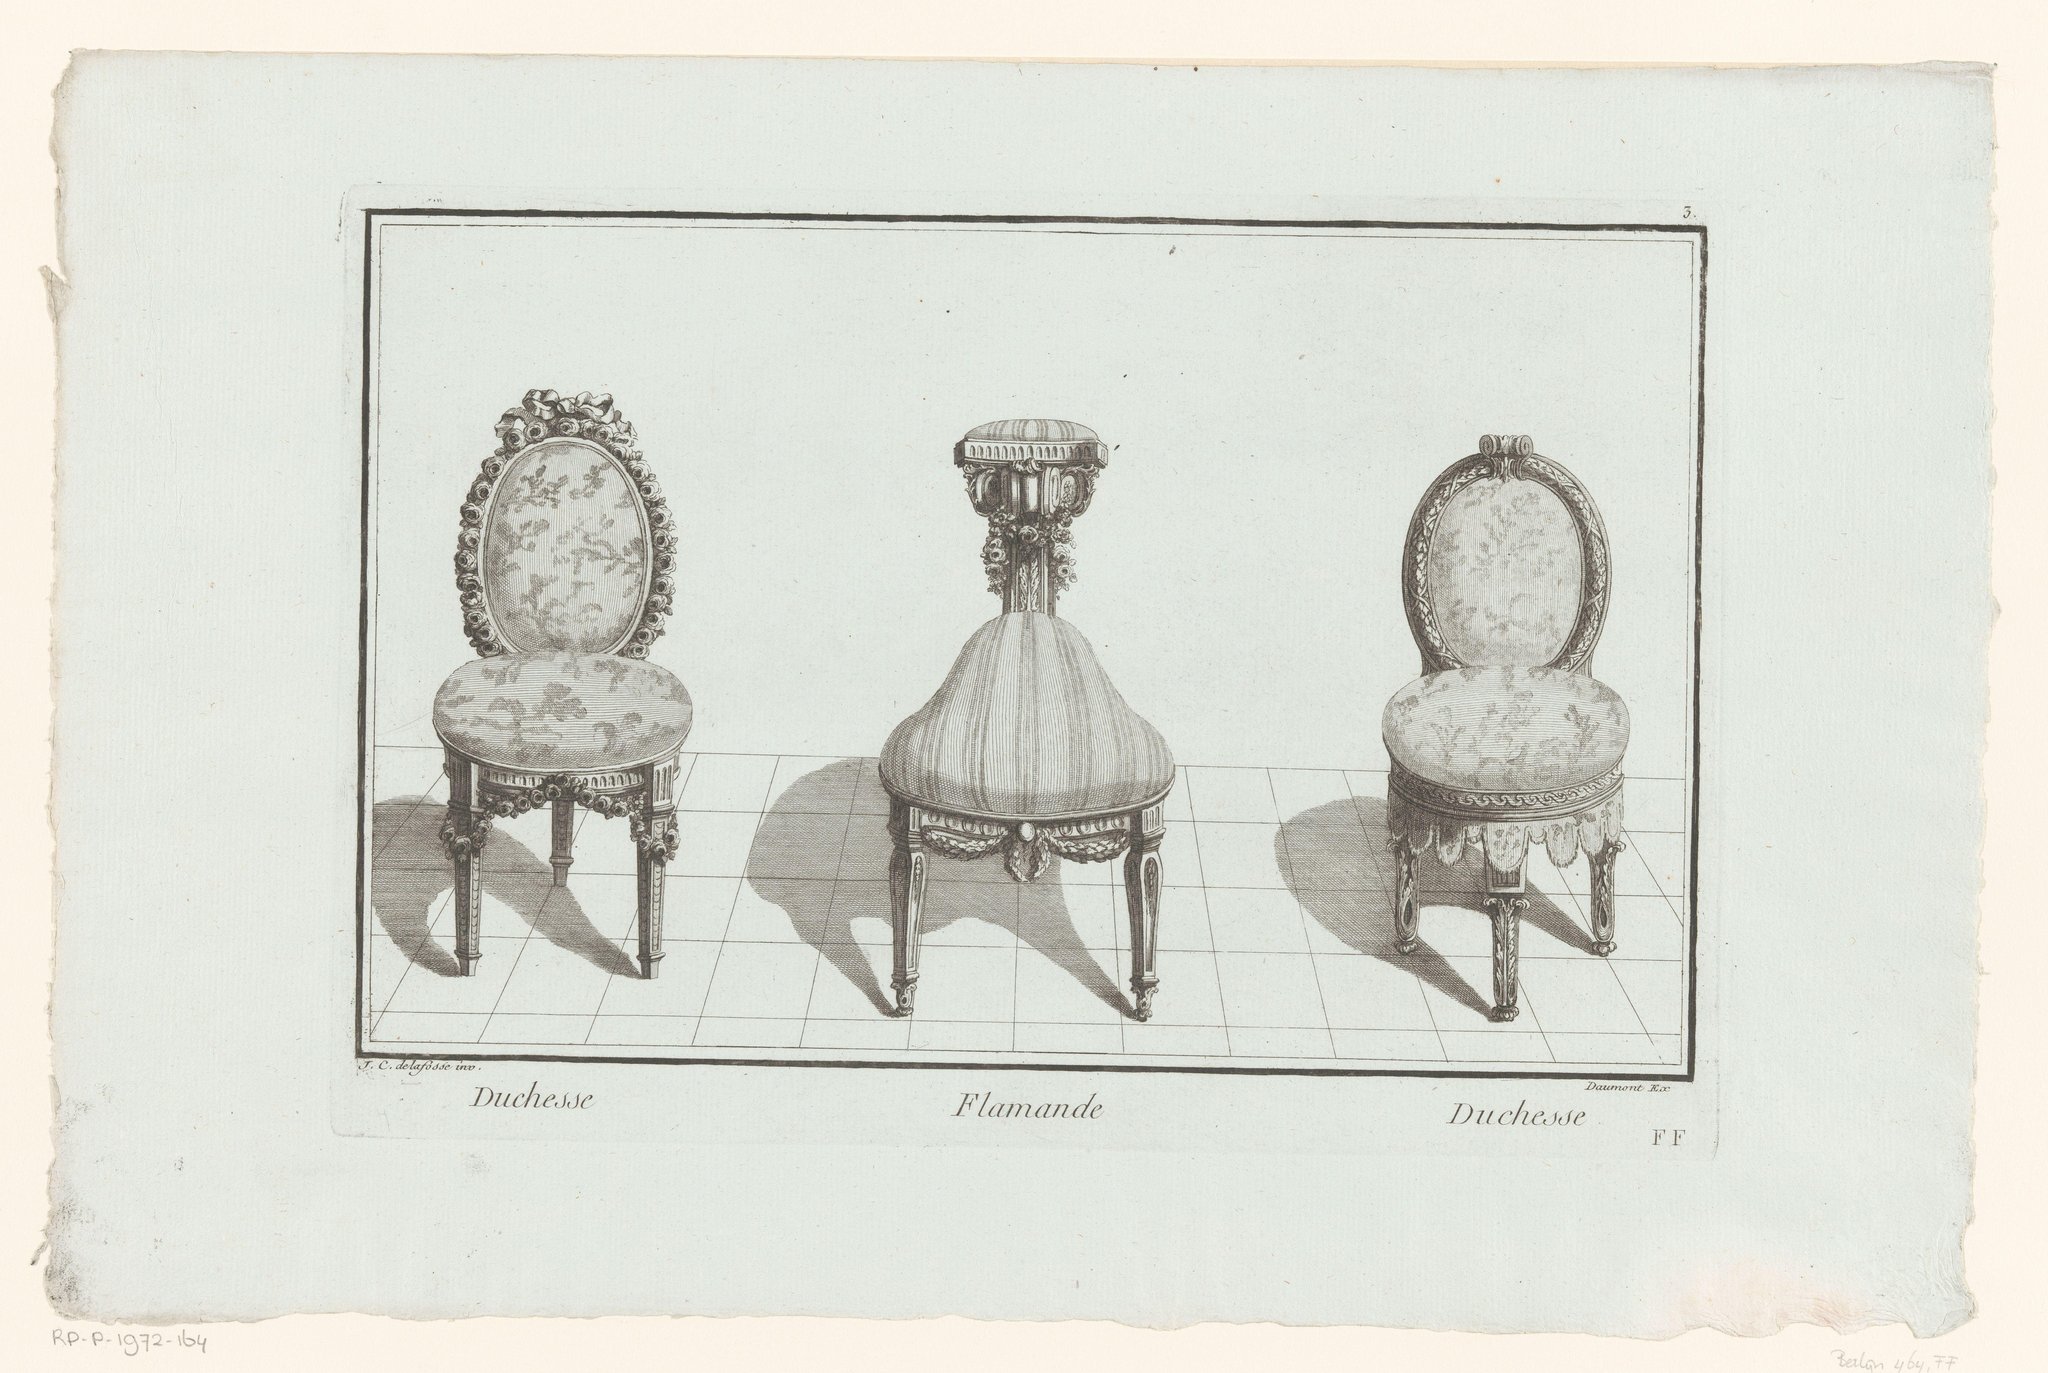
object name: print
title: FF Stoelen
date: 1745-1775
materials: paper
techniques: engraving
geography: paris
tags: chair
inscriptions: collector's mark: Lugt 2228, collector's mark: Lugt 2760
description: Twee stoelen met gebloemde bekleding en links met guirlandes en een stoel met driehoekige zitting en gestreepte bekleding.